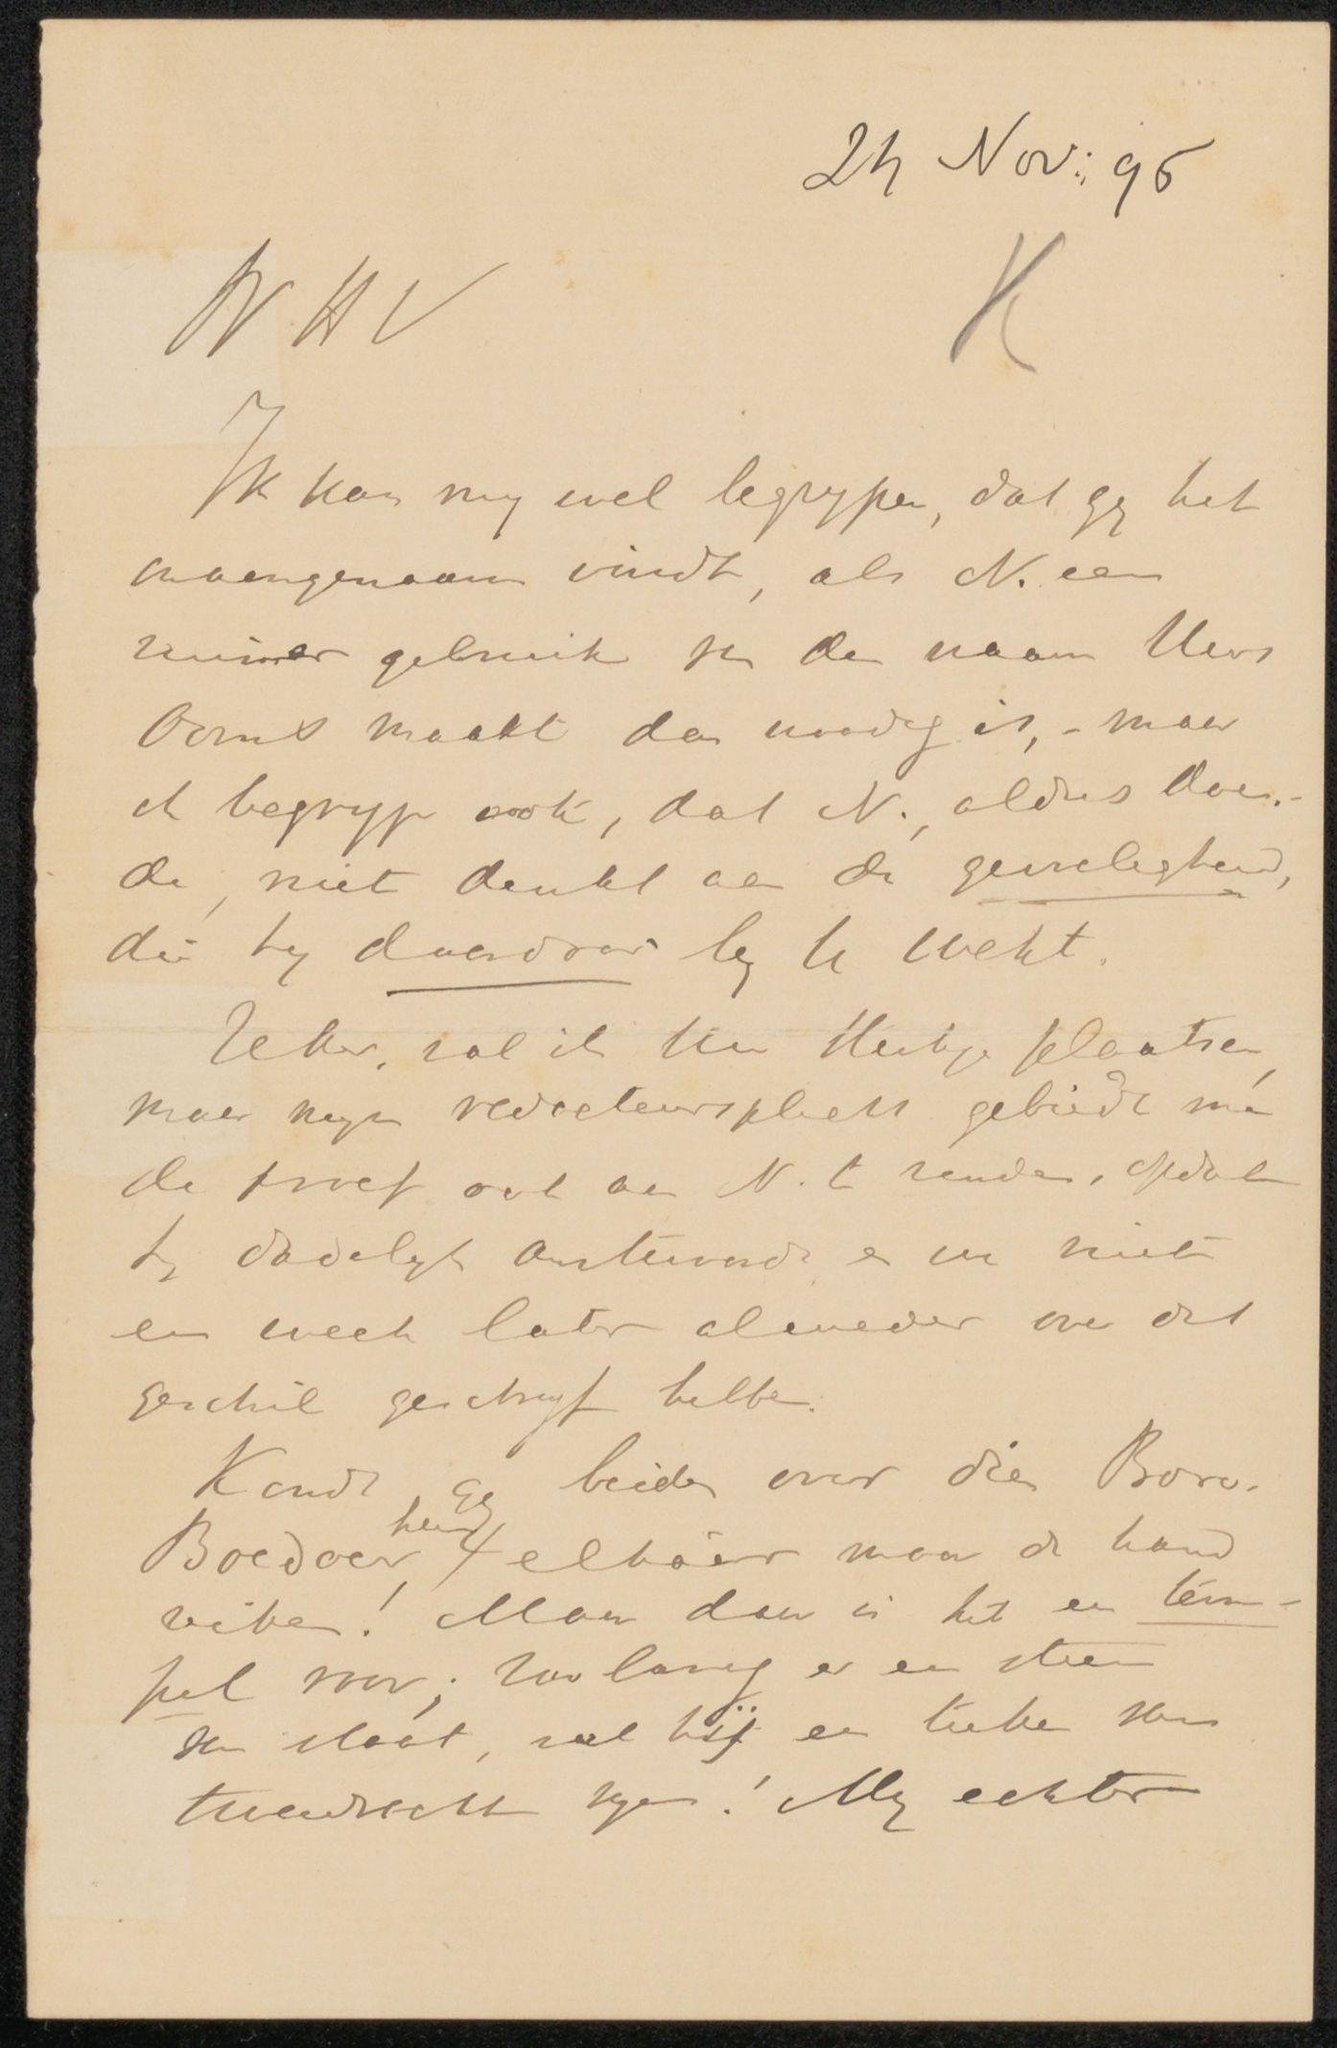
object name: letter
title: Brief aan Jan Veth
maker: johannes de koo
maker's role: auteur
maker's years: 1841-1909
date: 1895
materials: ink, paper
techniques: pen, writing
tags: dordrecht, painter, print maker, draughtsman, designer, jan veth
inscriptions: collector's mark: ‘RPK’